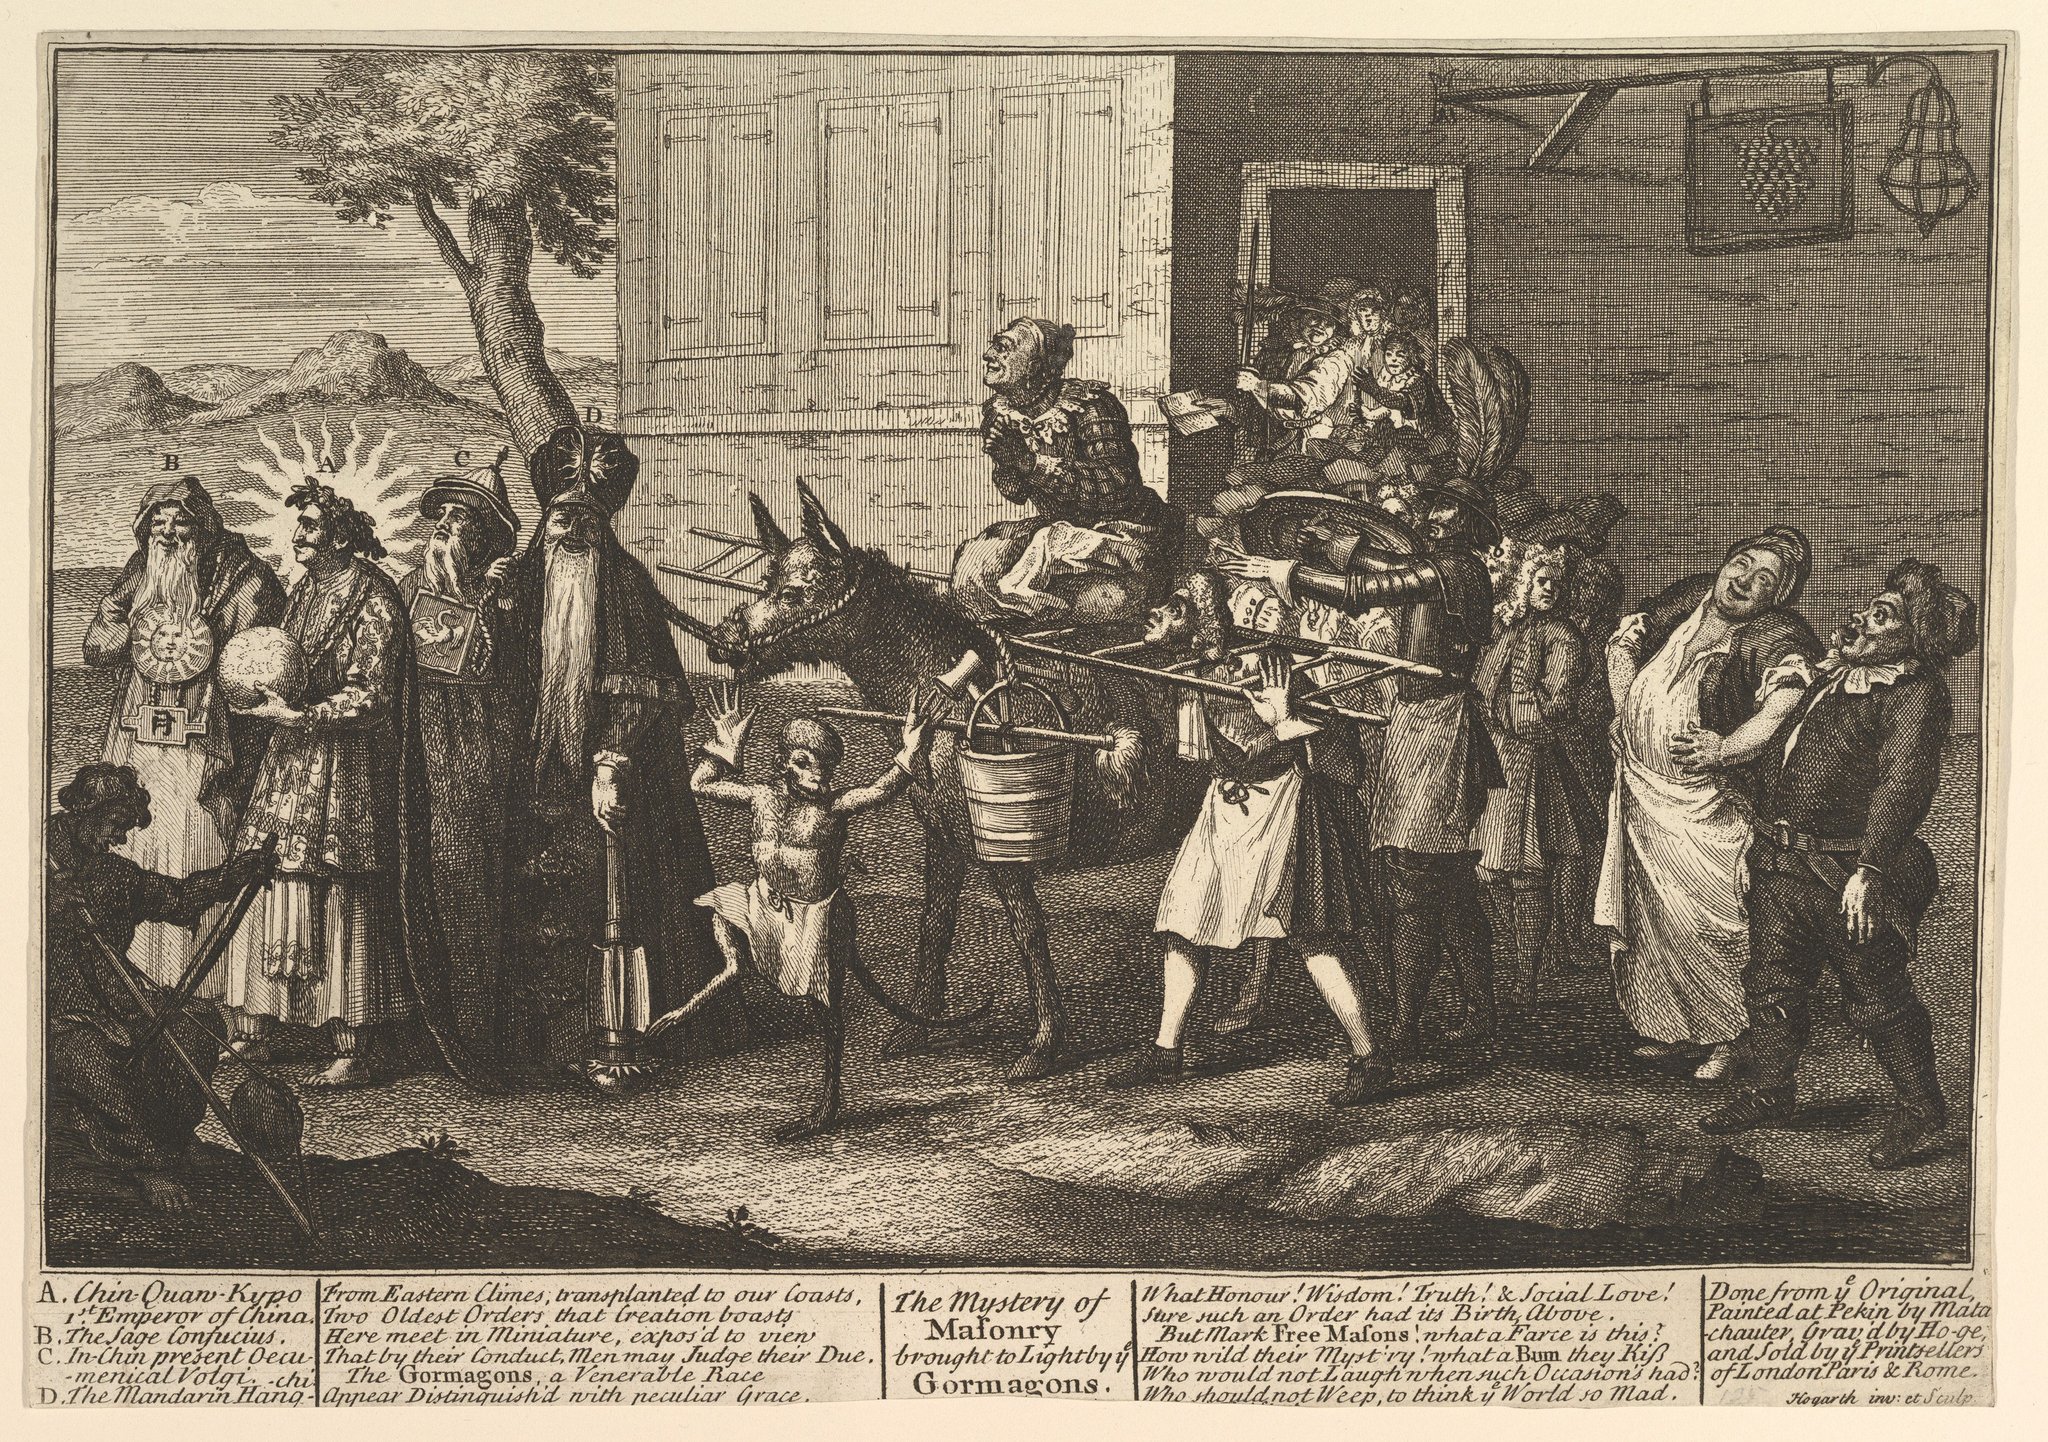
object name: print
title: The Mystery of Masonry Brought to Light by the Gormagons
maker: william hogarth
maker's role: artist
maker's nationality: british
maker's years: 1697-1764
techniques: engraving, etching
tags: men,donkeys,monkeys,ladders